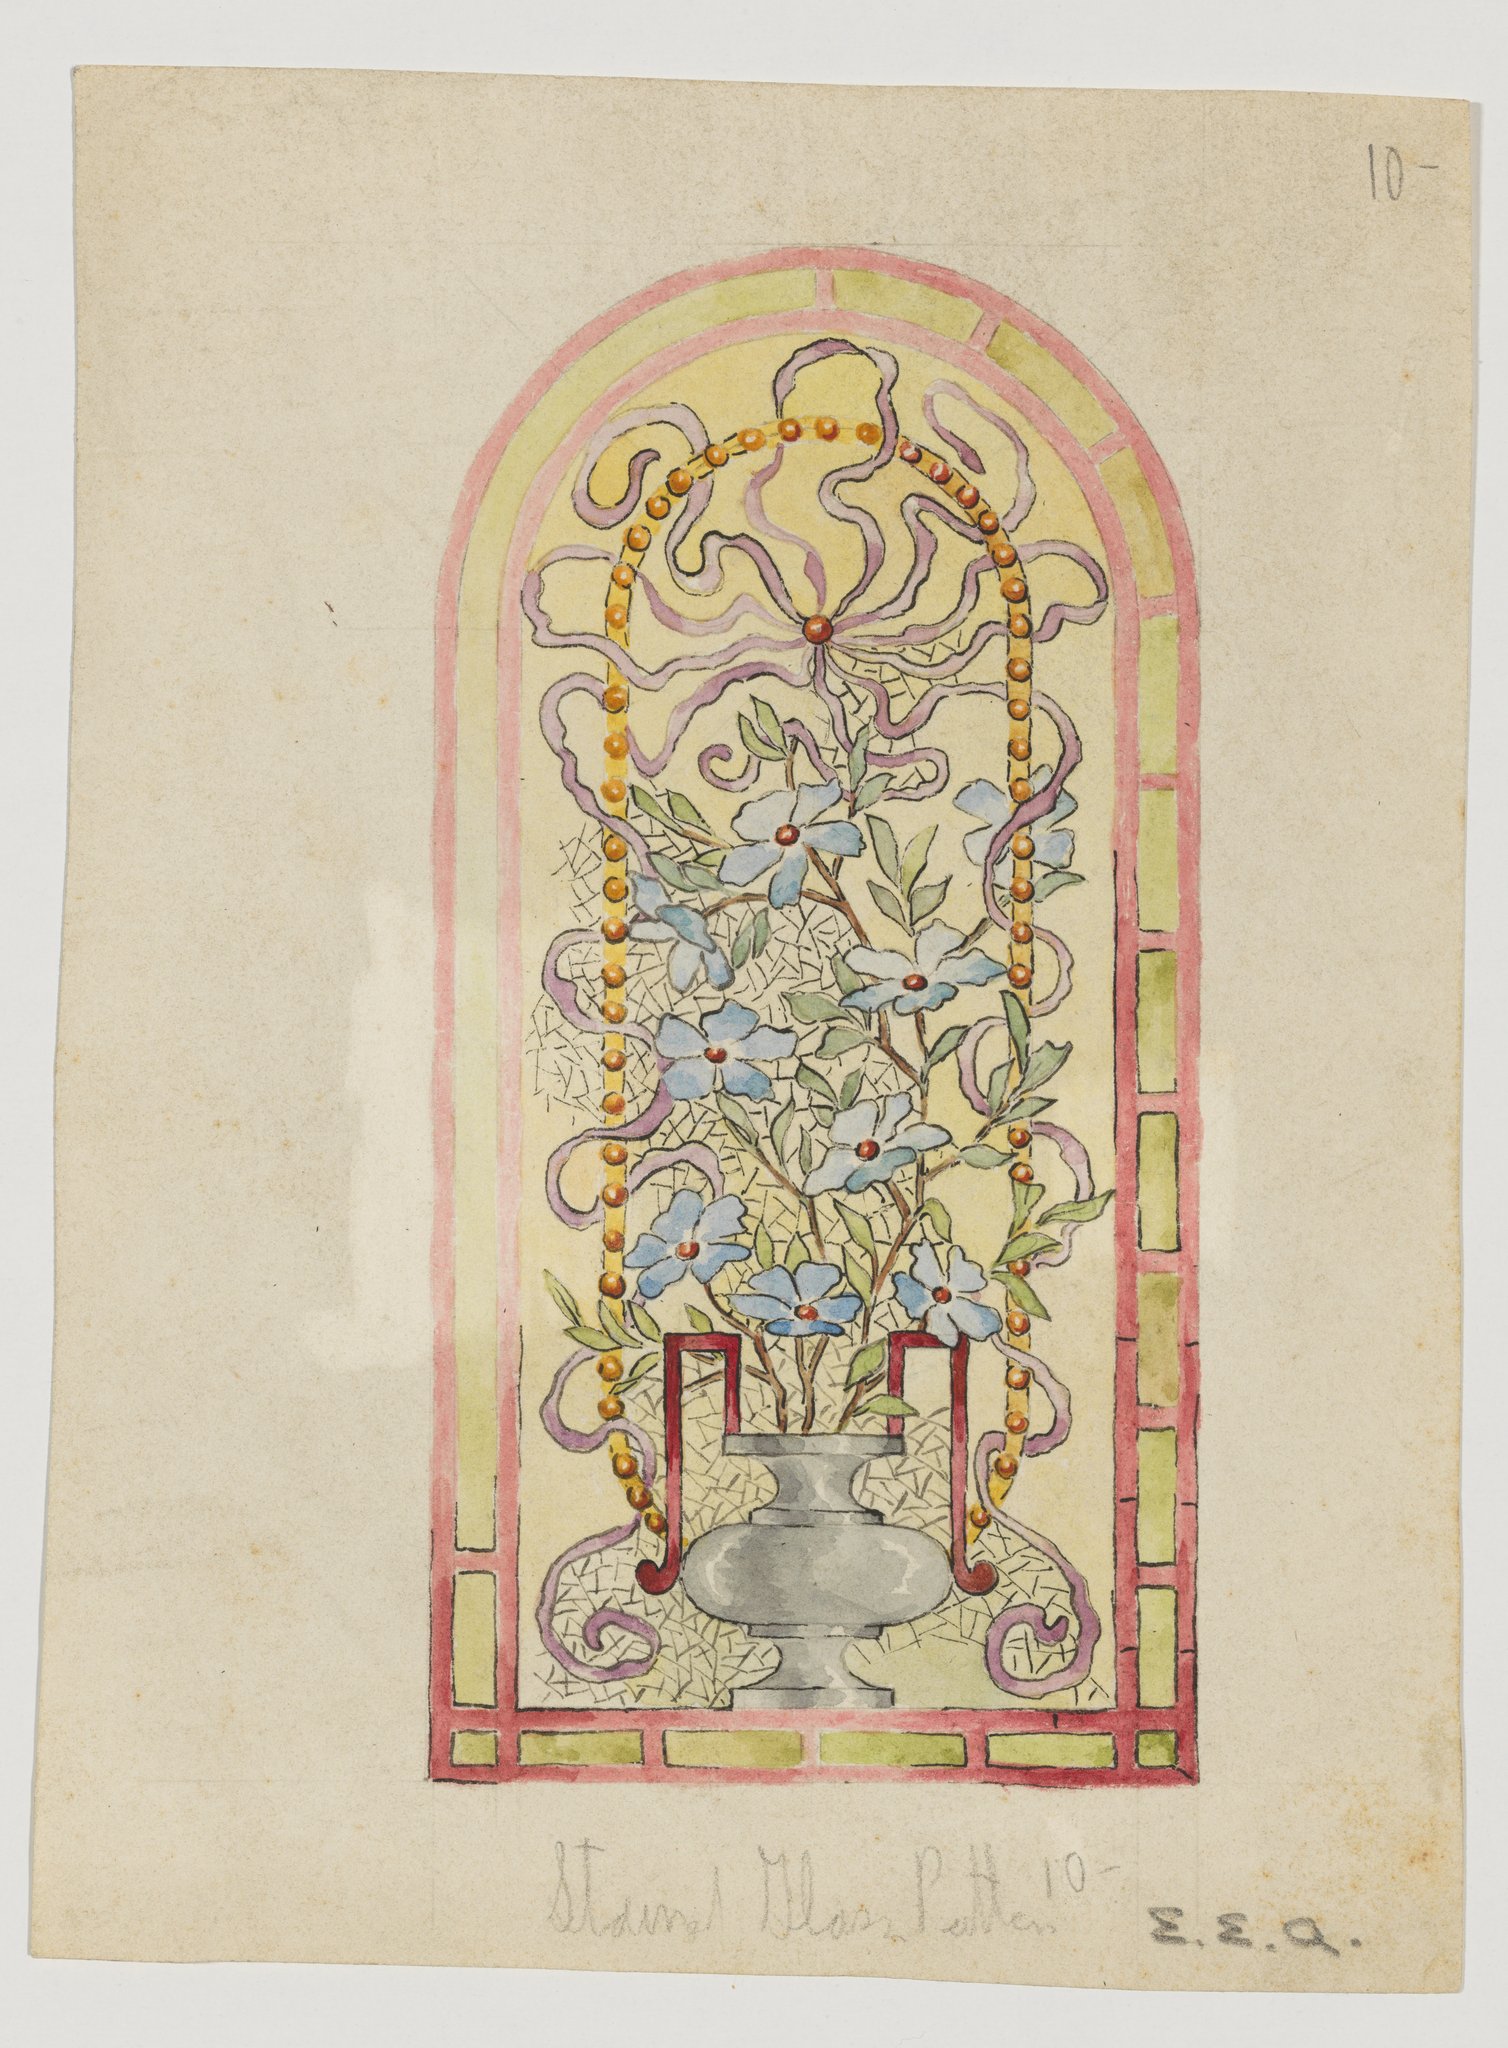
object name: drawing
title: Stained Glass Design with Flowering Vase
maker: e. e. q.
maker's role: artist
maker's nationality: american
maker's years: 1800-1900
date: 1867-1900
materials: ink, watercolor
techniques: pen